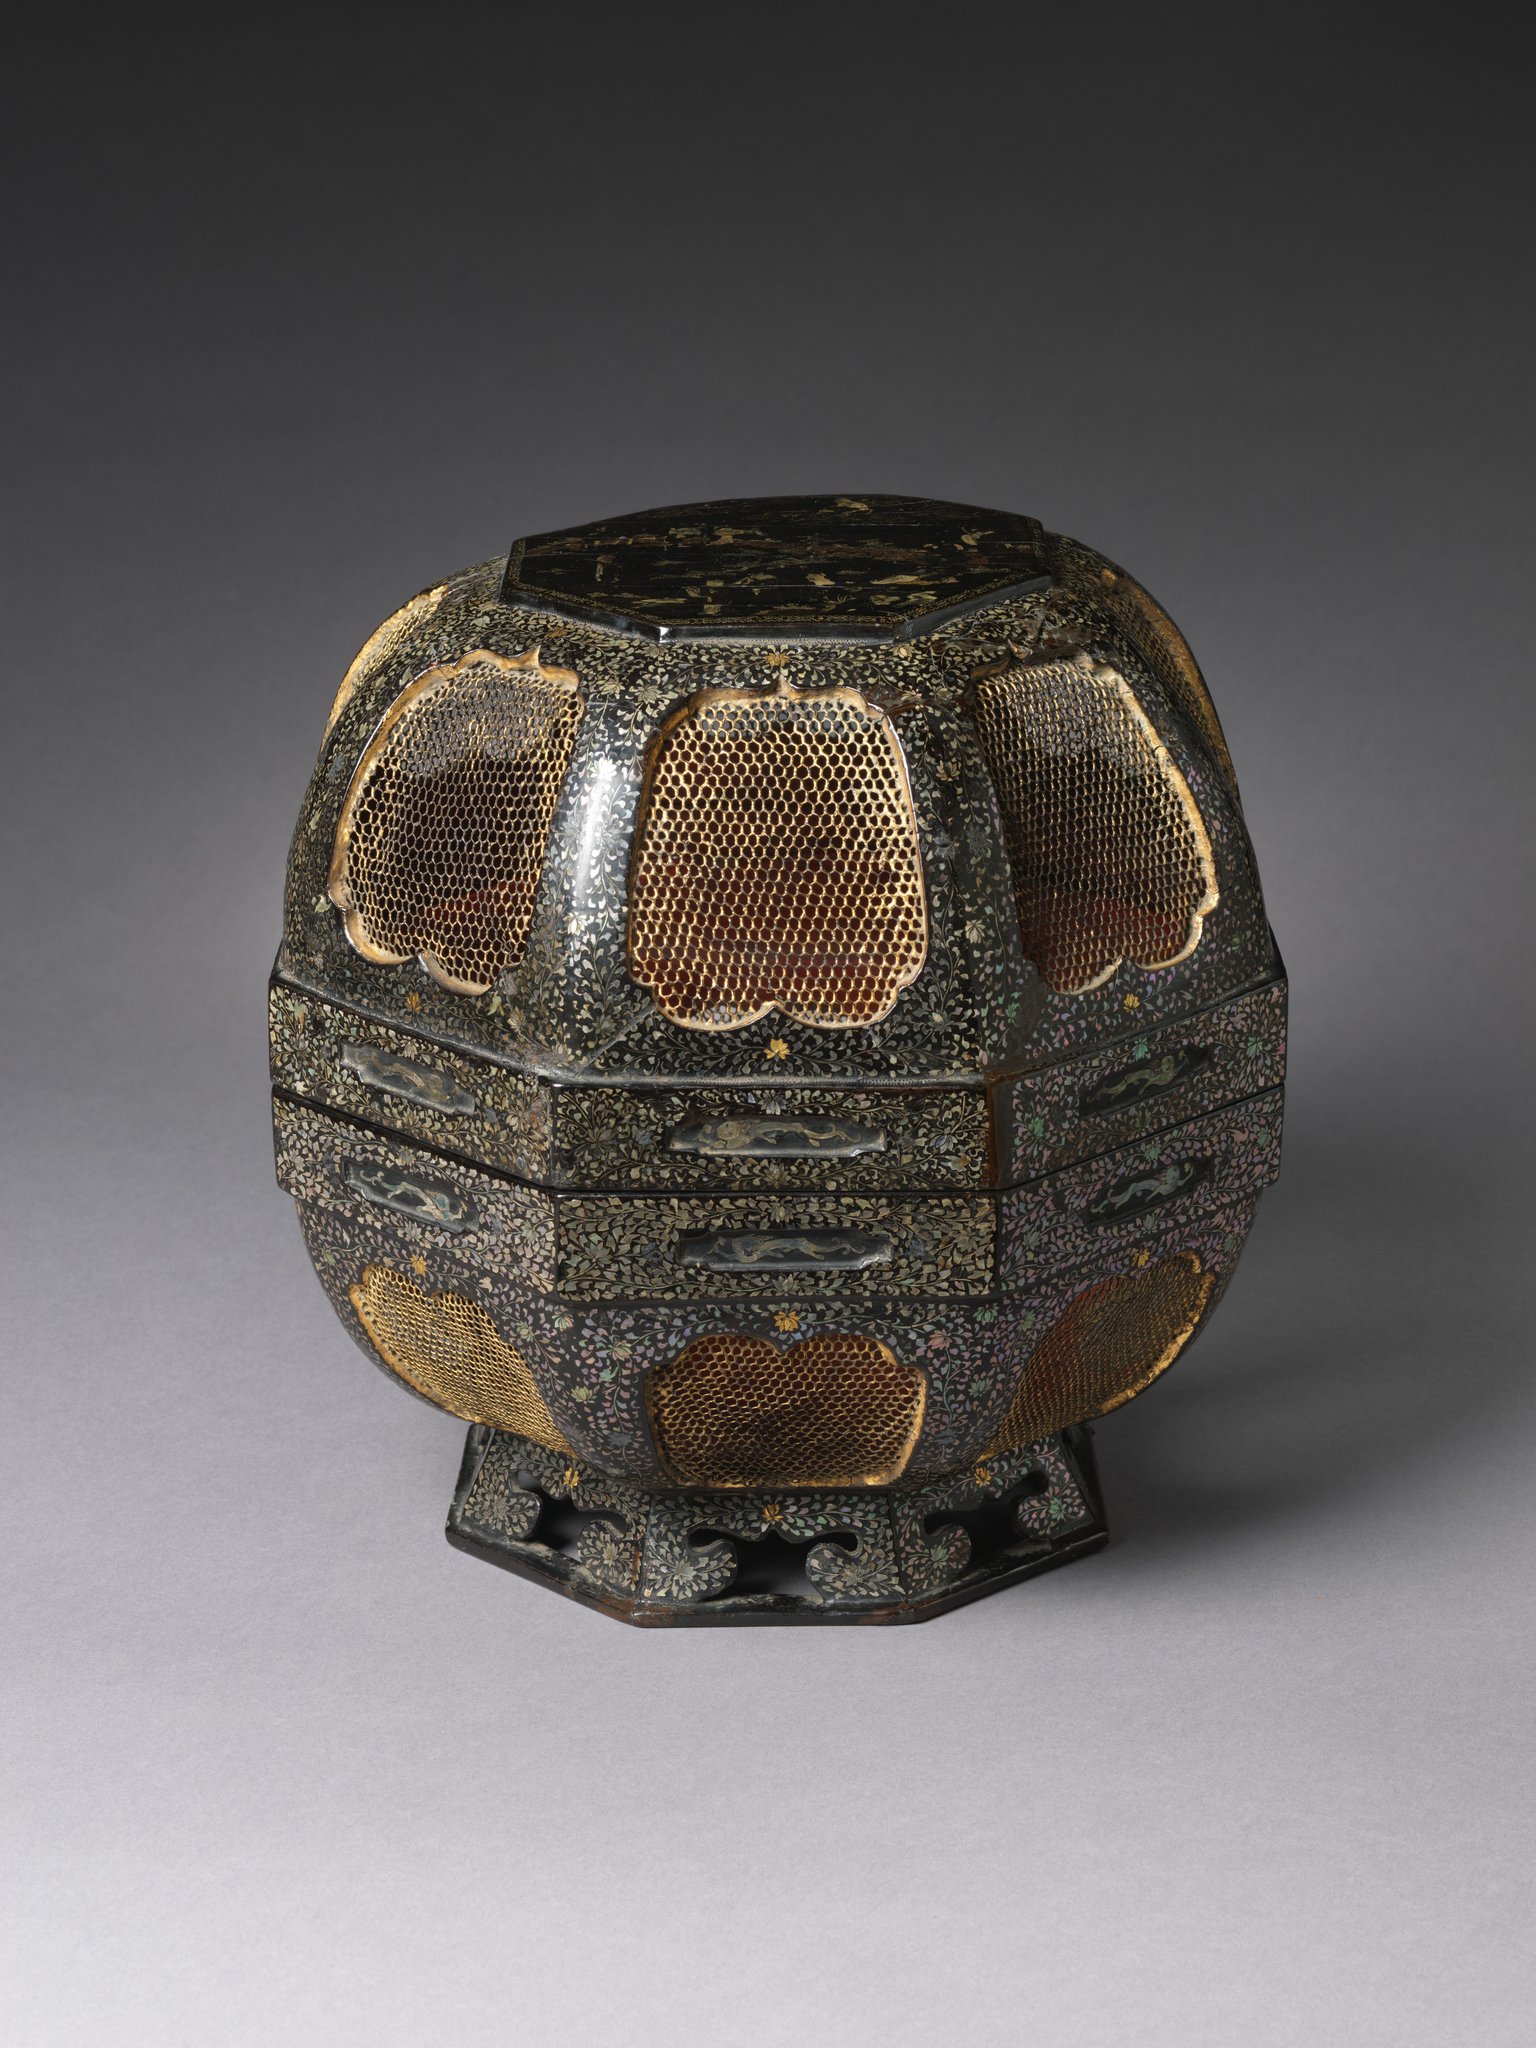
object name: box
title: Octagonal food box with Chinese immortals and floral design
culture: japanese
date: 1701-1800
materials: gold leaf, metal, mother of pearl, wood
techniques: gilding, inlay, lacquer